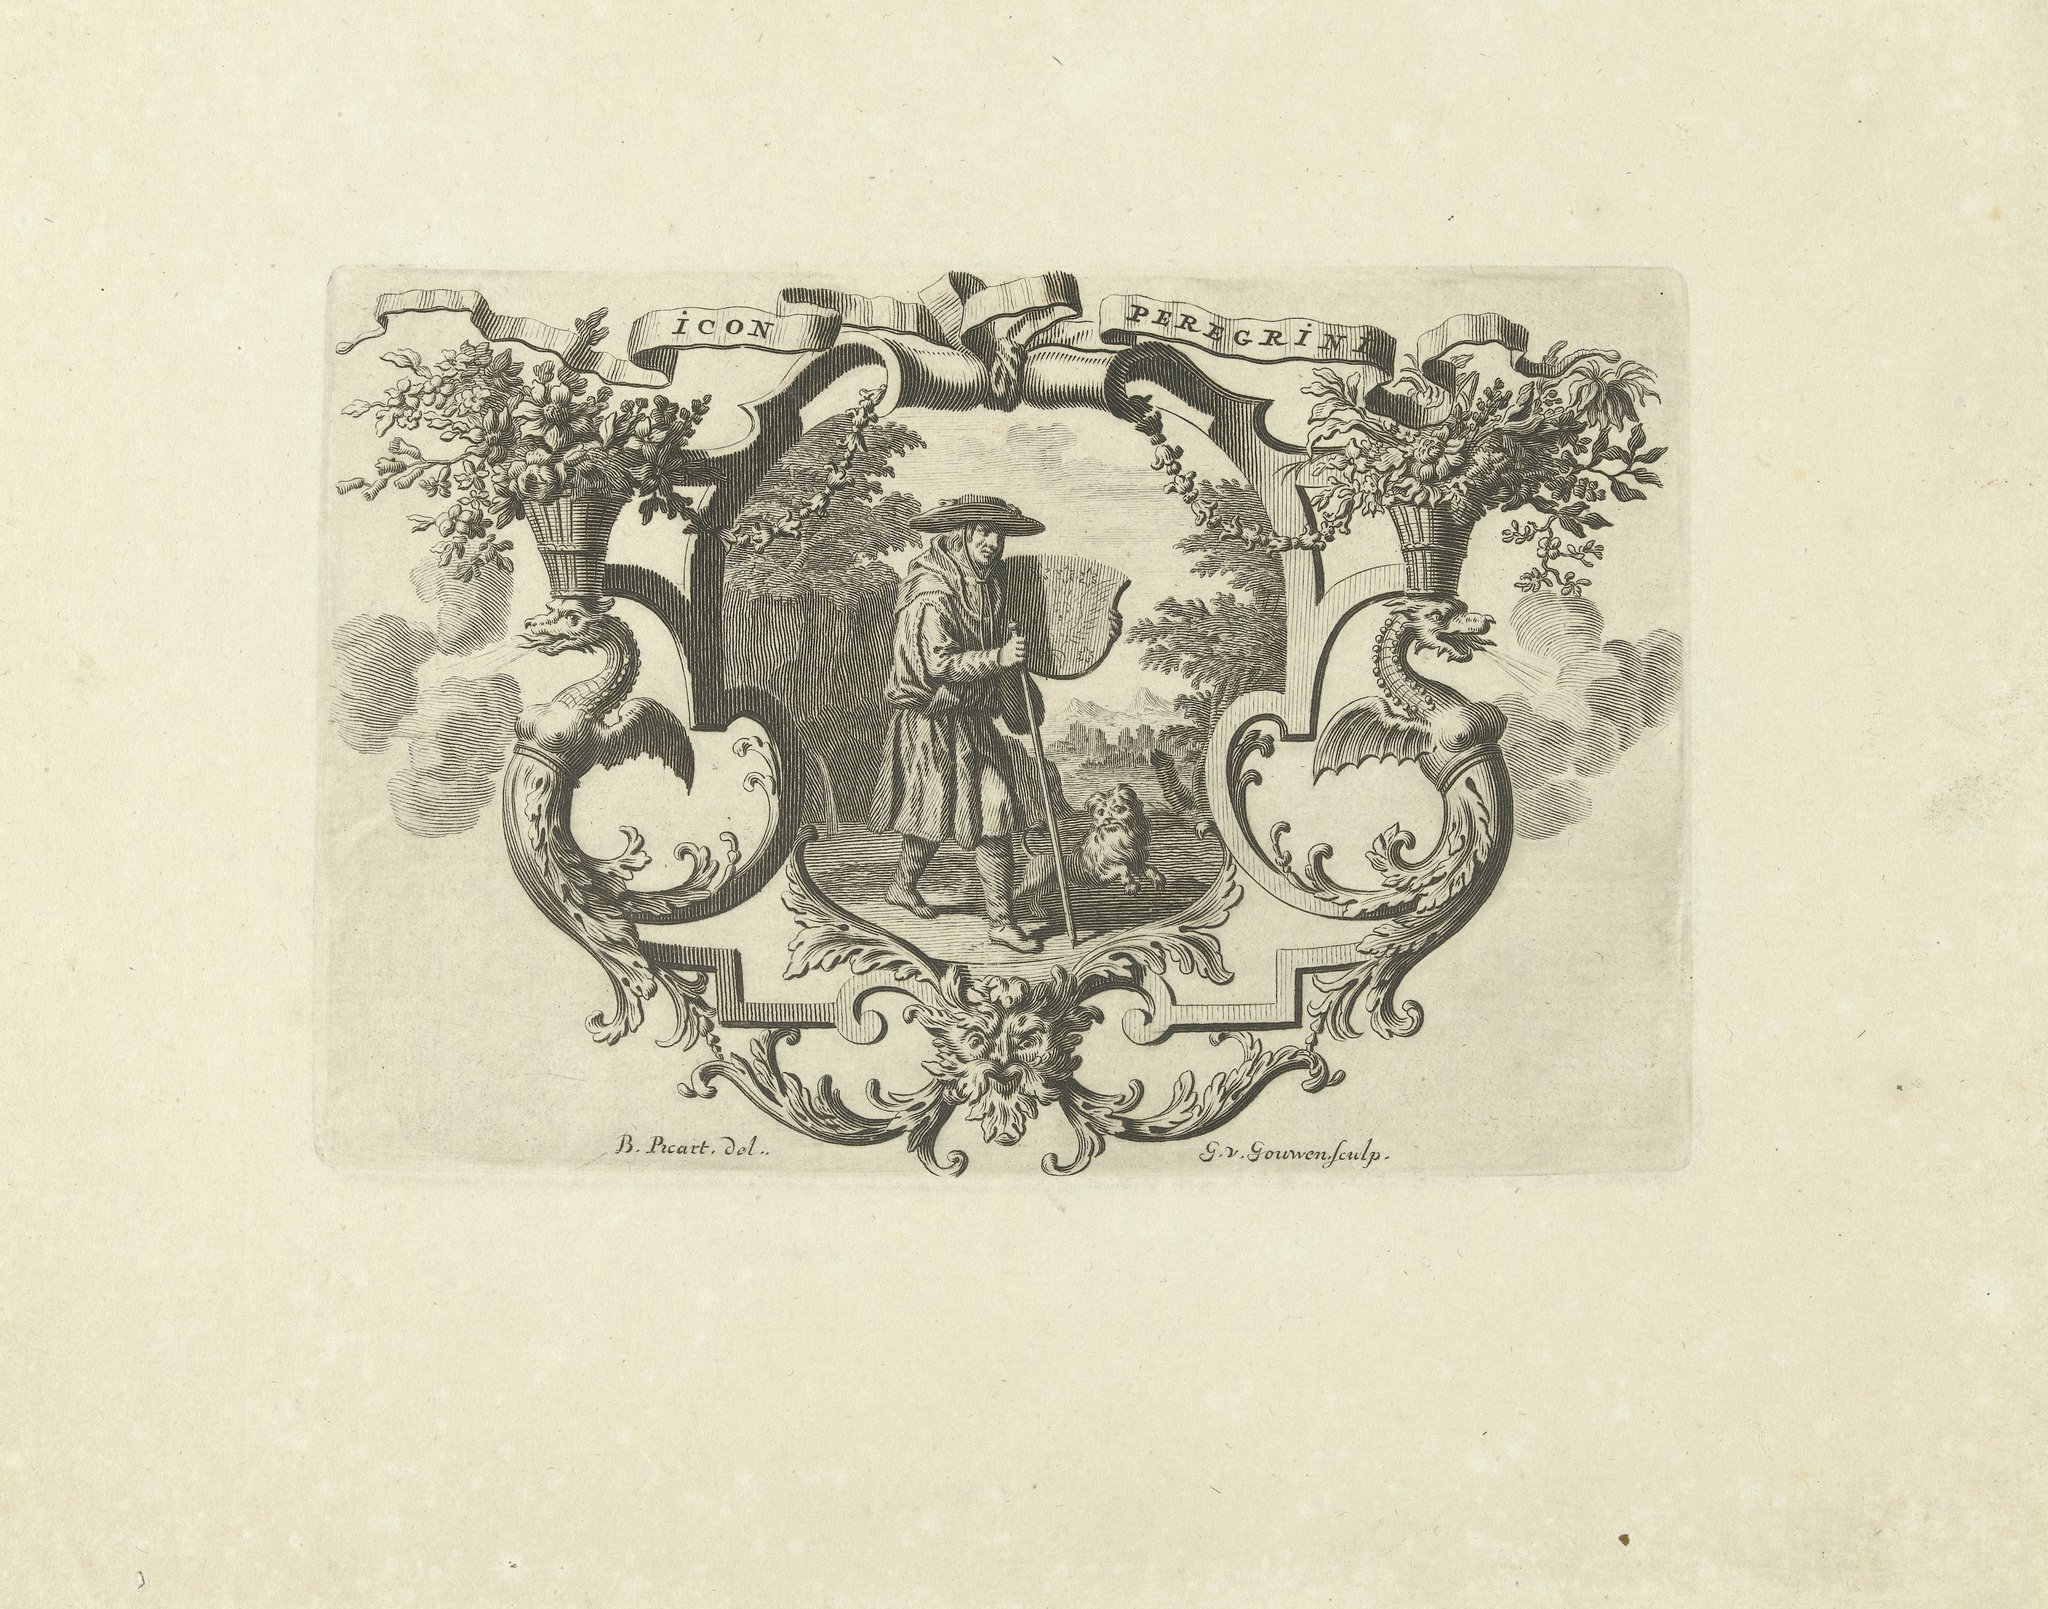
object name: print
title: Pelgrim met een hond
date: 1670-1740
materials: paper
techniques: engraving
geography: amsterdam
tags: ornament ~ hybrid animals, (story of) mercury (hermes), pilgrim(s), dog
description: Emblematische voorstelling: Mercurius als een pelgrim met een hond. In zijn hand een schild met een zon en drie sterren. Rondom de voorstelling ornamenten met fabelwezens.